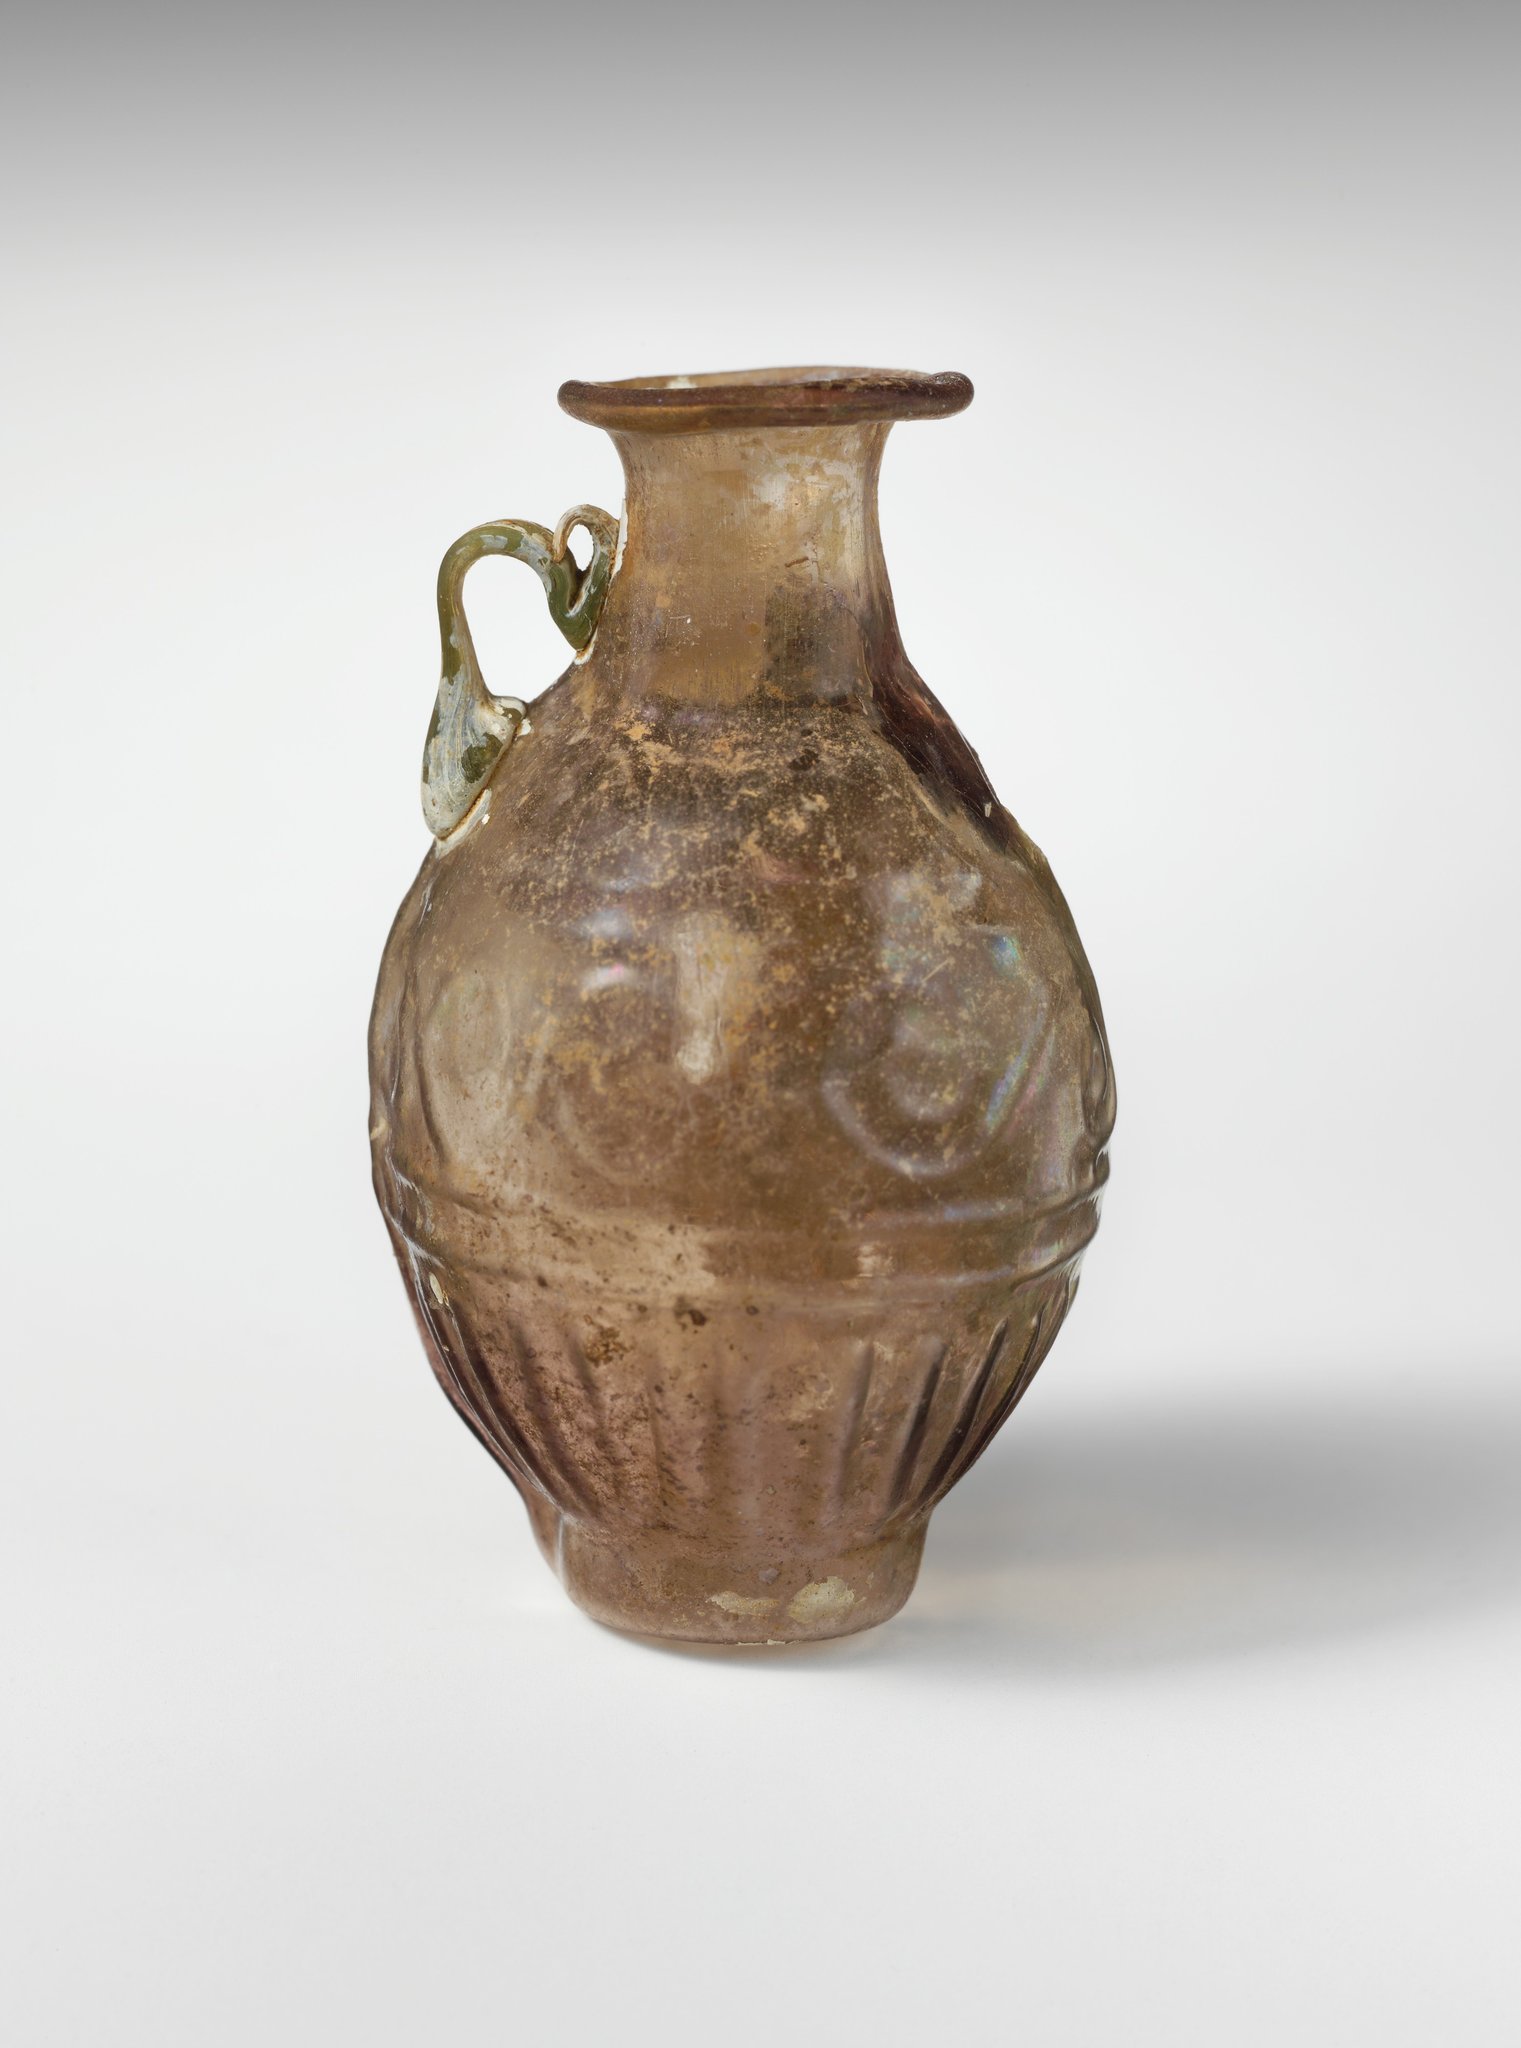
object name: amphoriskos, scroll band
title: Glass amphoriskos with band of scrolls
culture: roman, syro-palestinian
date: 1-100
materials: glass